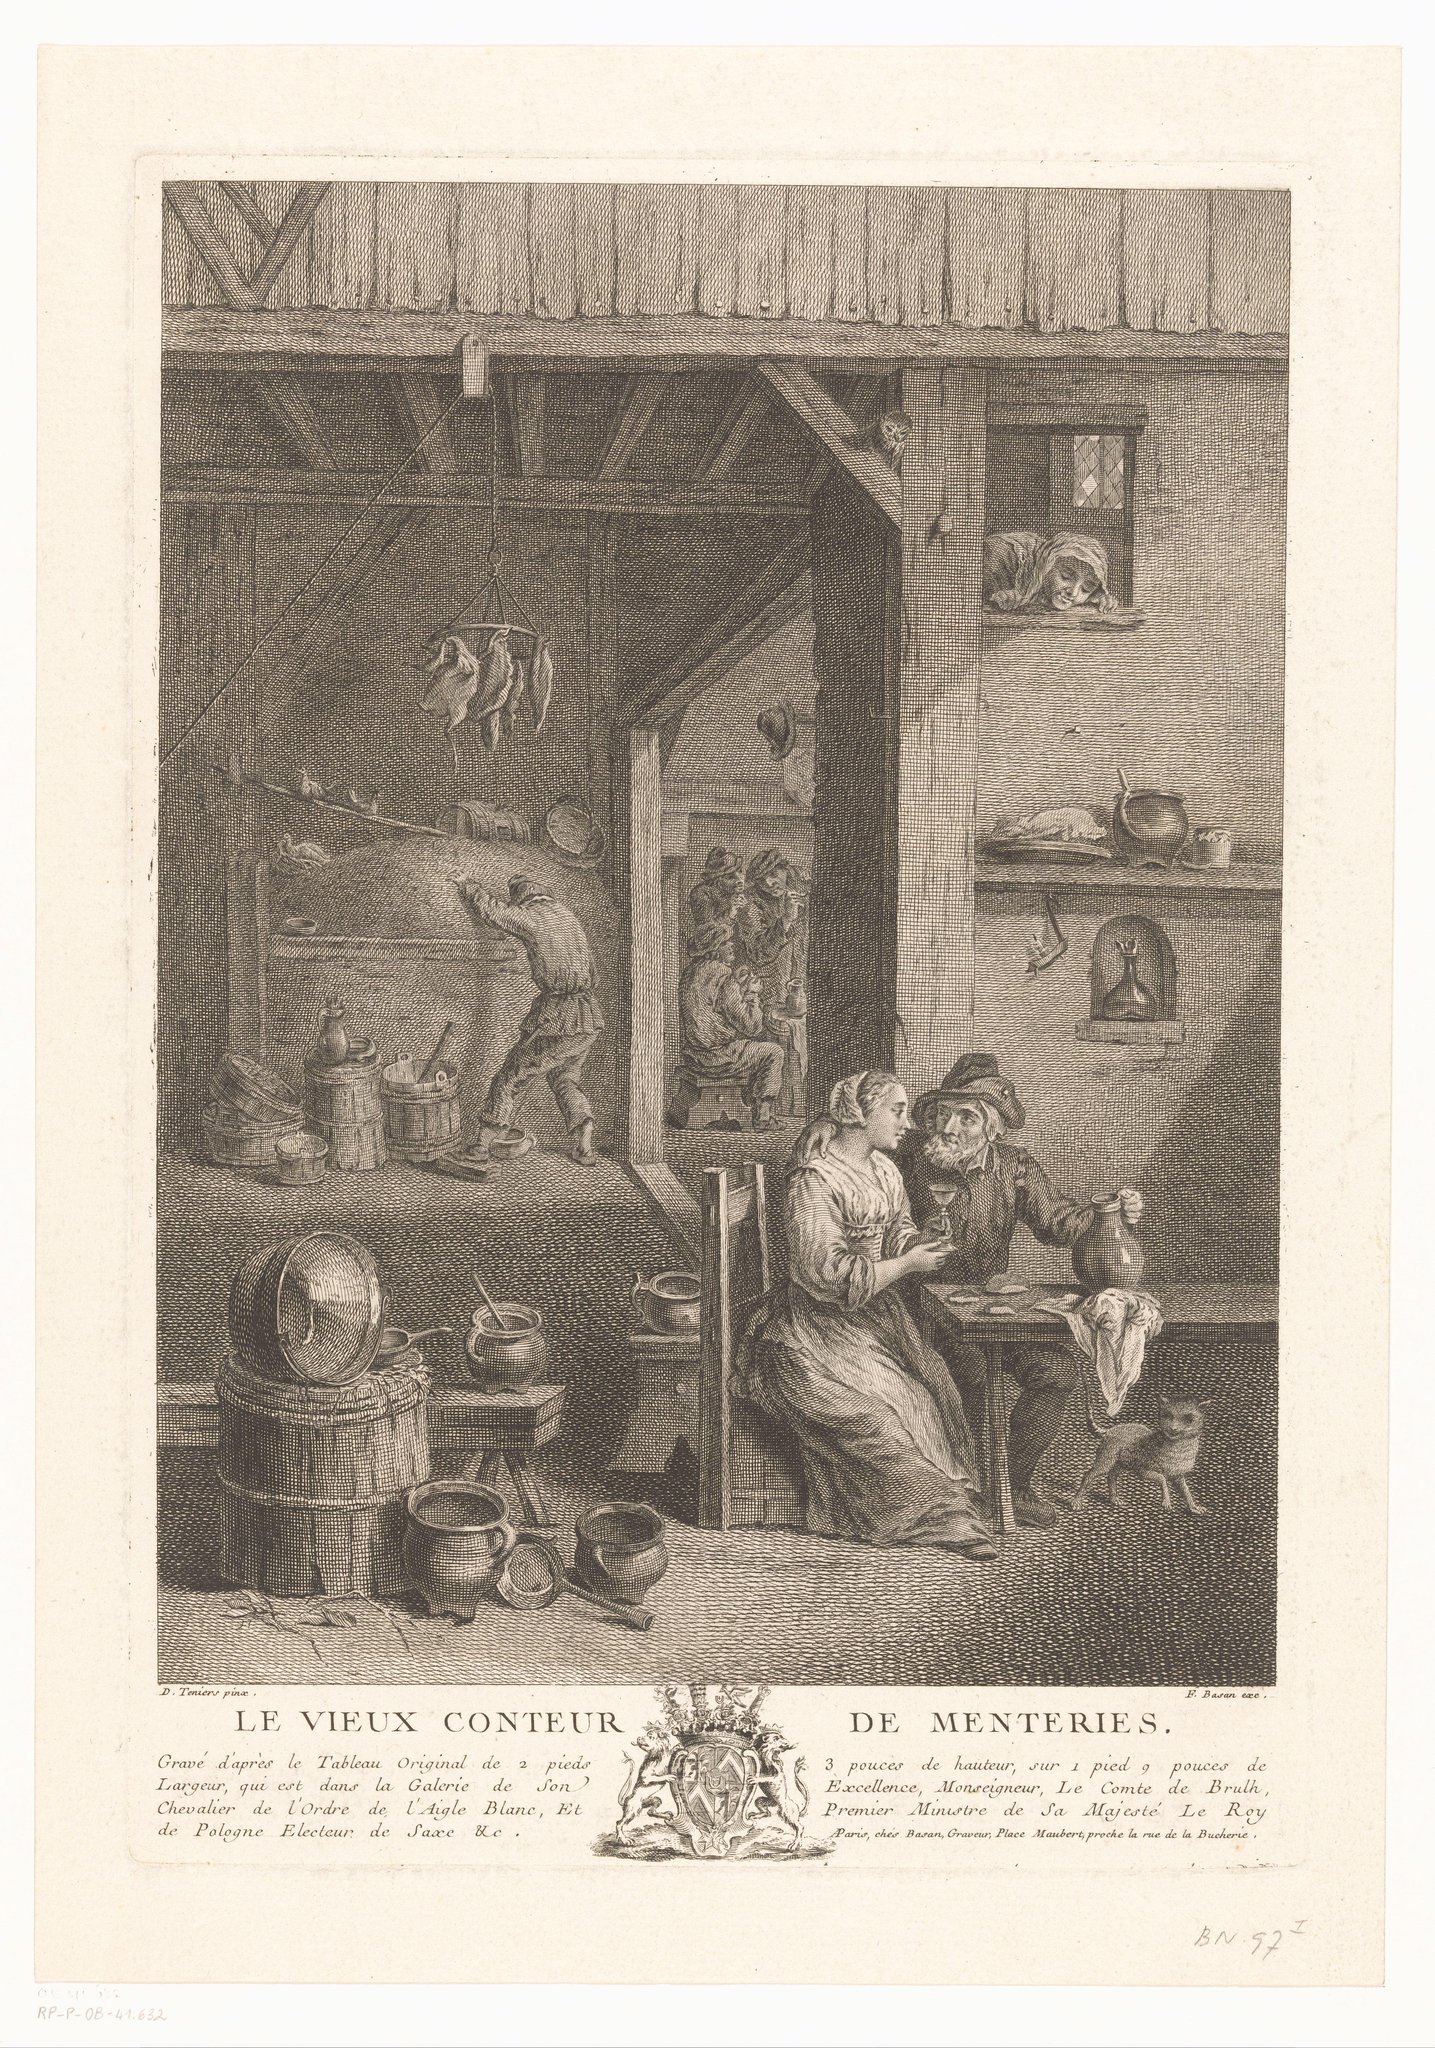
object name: print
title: Le vieux conteur de menteries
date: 1733-1797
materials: paper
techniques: engraving, etching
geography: paris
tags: cat, hotel, hostelry, inn, lie; 'bugia' (ripa)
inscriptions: collector's mark: Lugt 2228